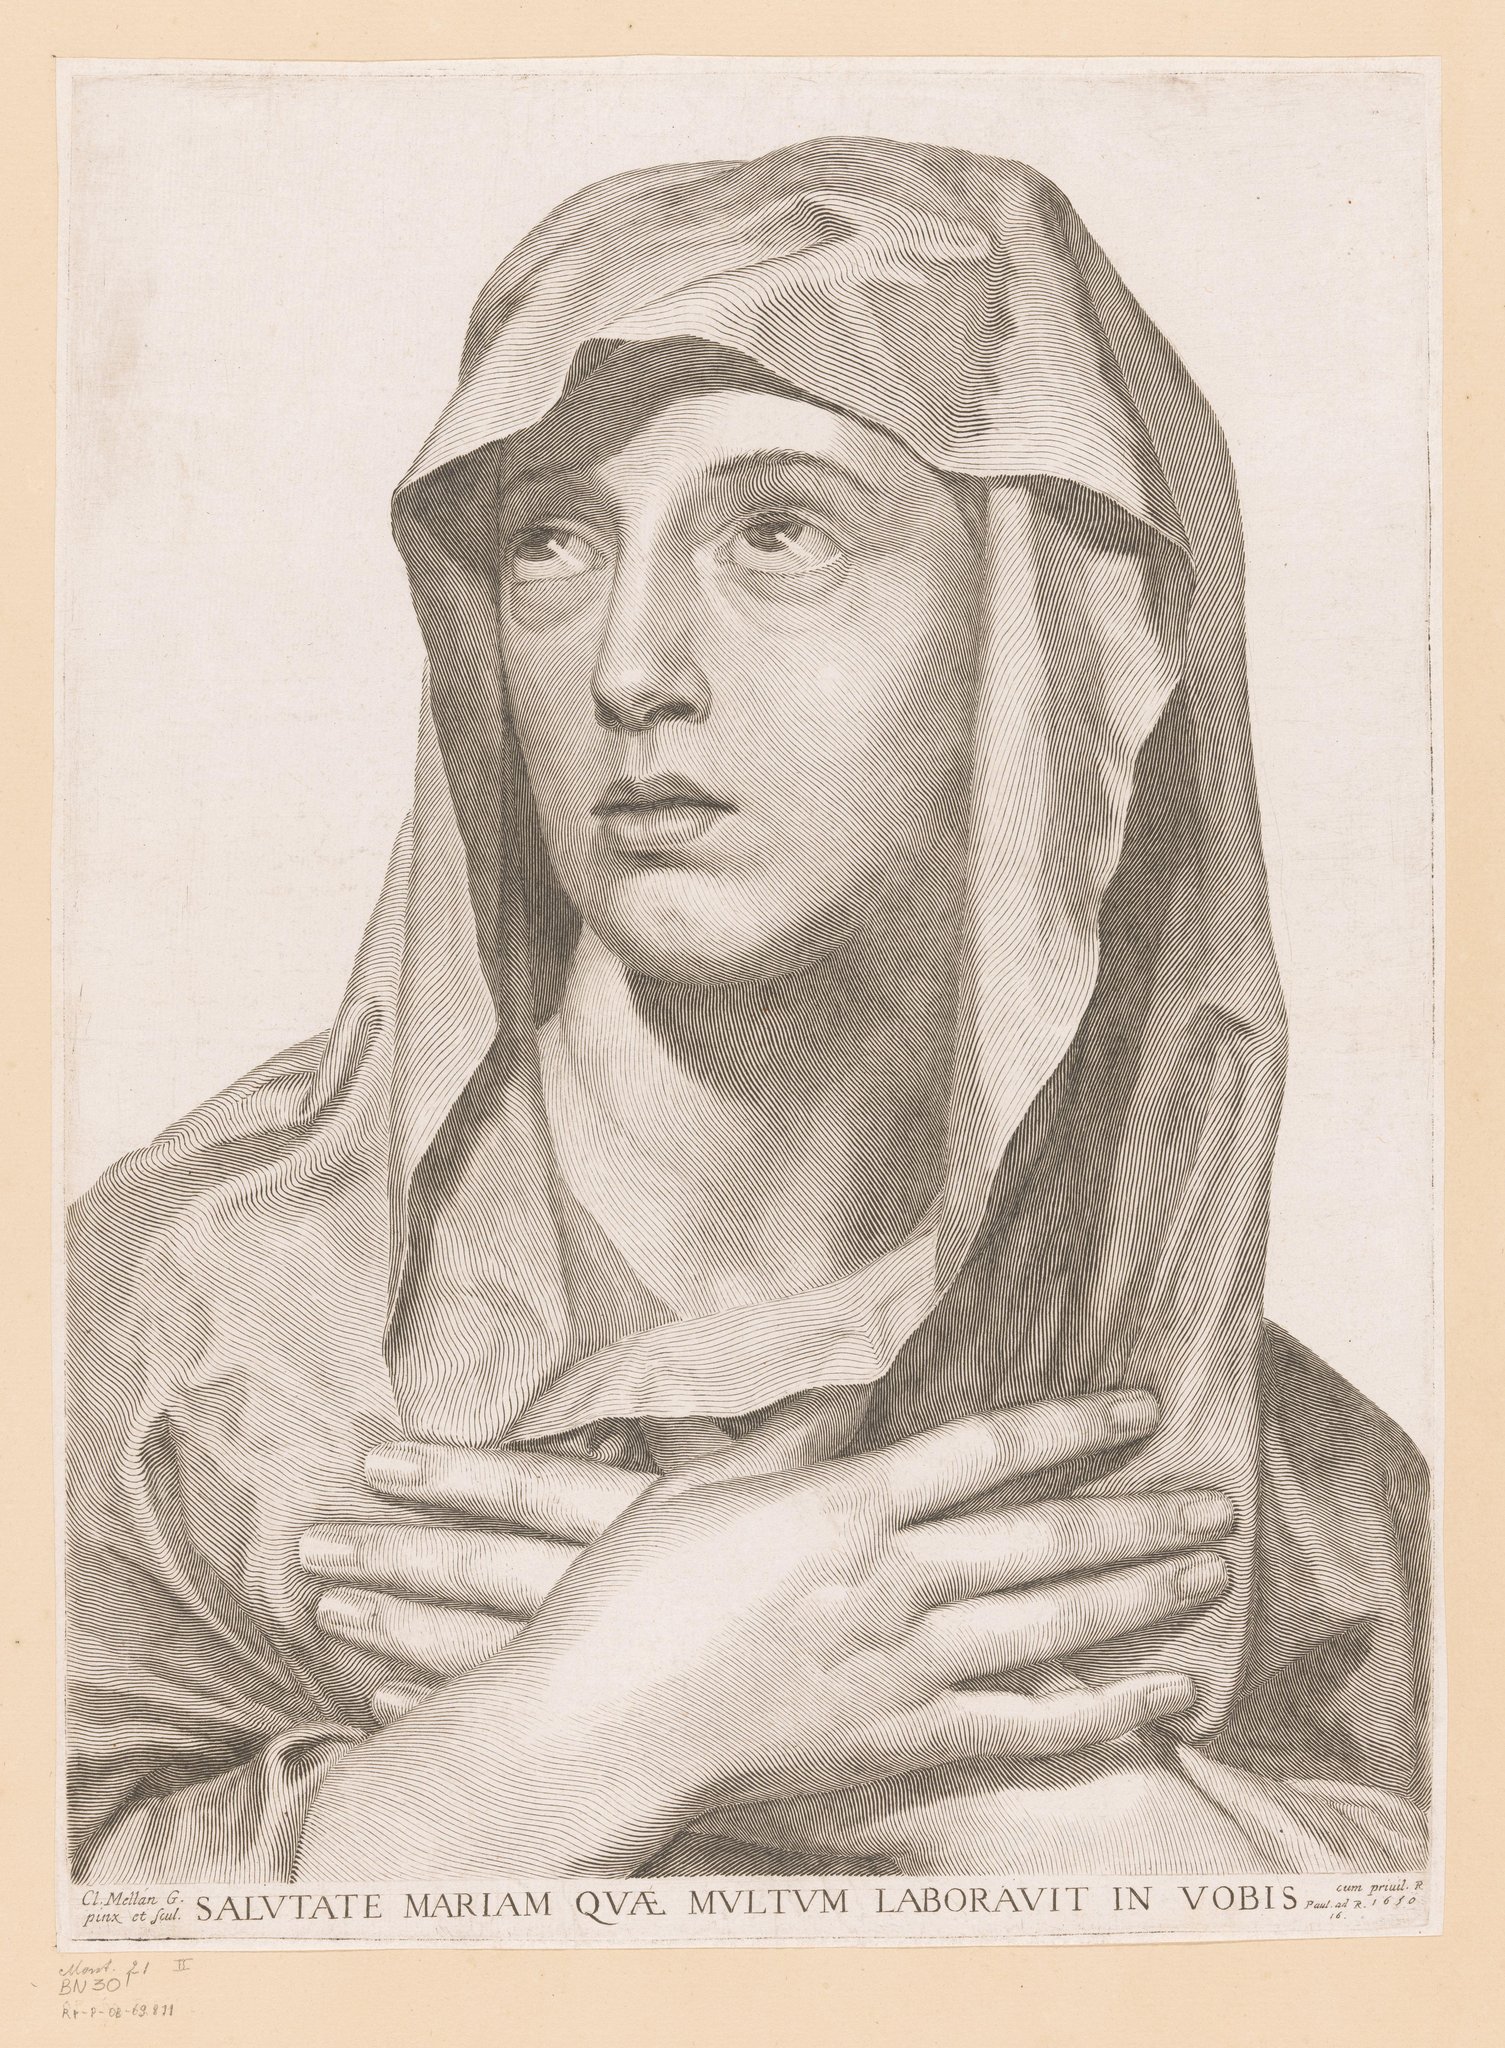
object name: print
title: Maria met gekruiste handen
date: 1650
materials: paper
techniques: engraving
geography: france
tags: 'portraits' of mary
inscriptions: watermark, collector's mark: Lugt 240